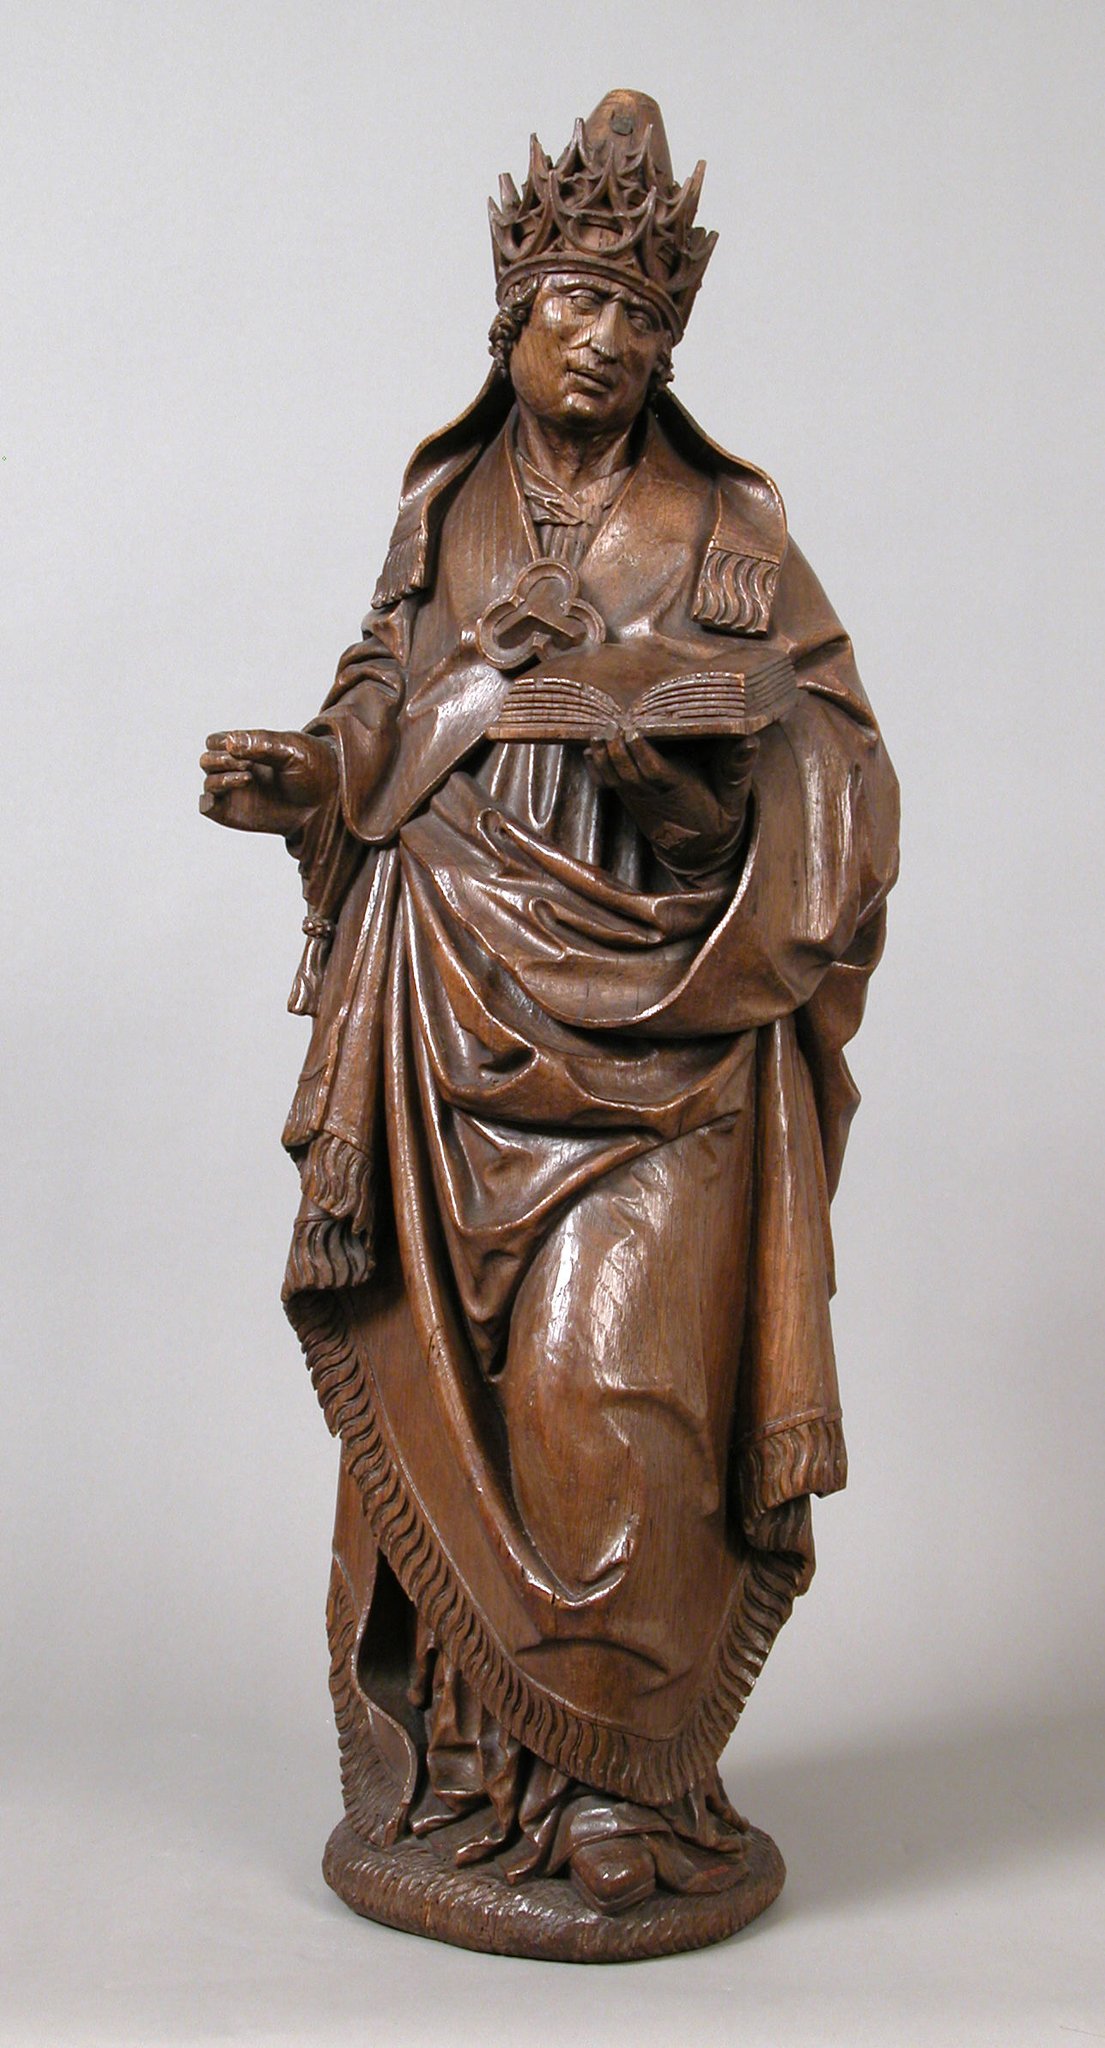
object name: statuette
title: Saint Gregory as Pope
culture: german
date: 1500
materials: wood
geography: germany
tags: men,popes